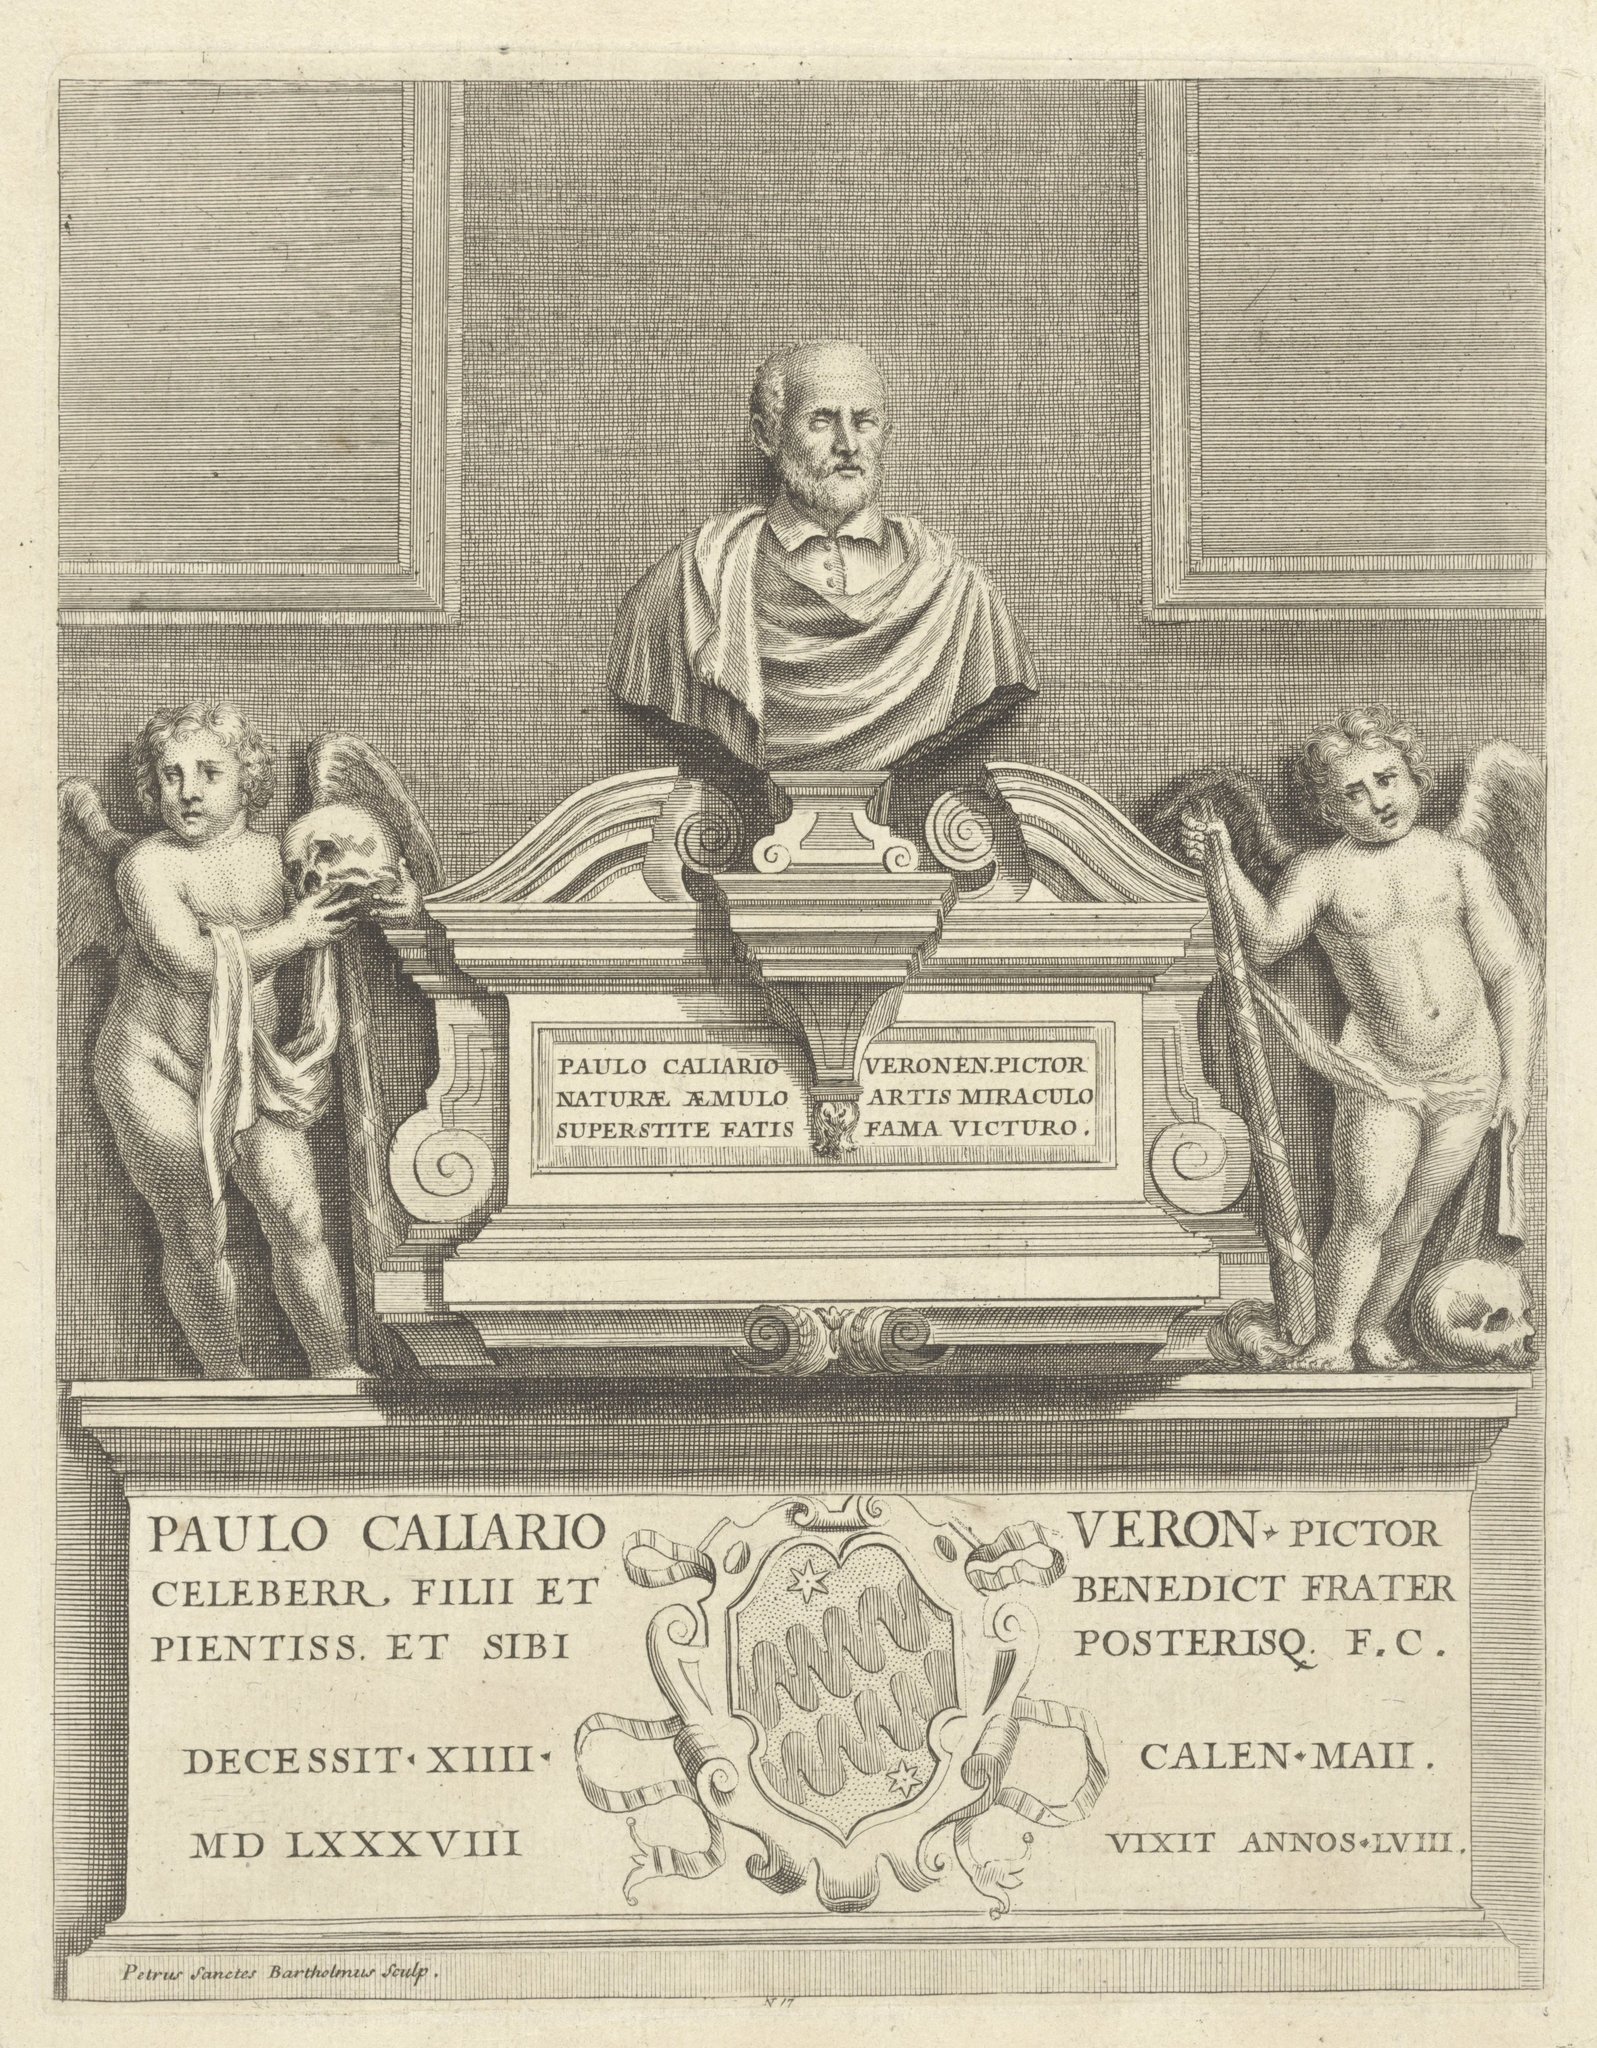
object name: print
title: Graftombe van Paolo Veronese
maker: pietro sante bartoli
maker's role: draughtsman, painter, print maker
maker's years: 1615-1700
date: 1645-1700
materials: paper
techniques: engraving, etching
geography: italy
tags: venice, painter, draughtsman, paolo veronese, grave, tomb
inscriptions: collector's mark: Lugt 240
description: Graftombe van schilder Paolo Veronese met portret en twee putti. In ondermarge tekst en een wapenschild.